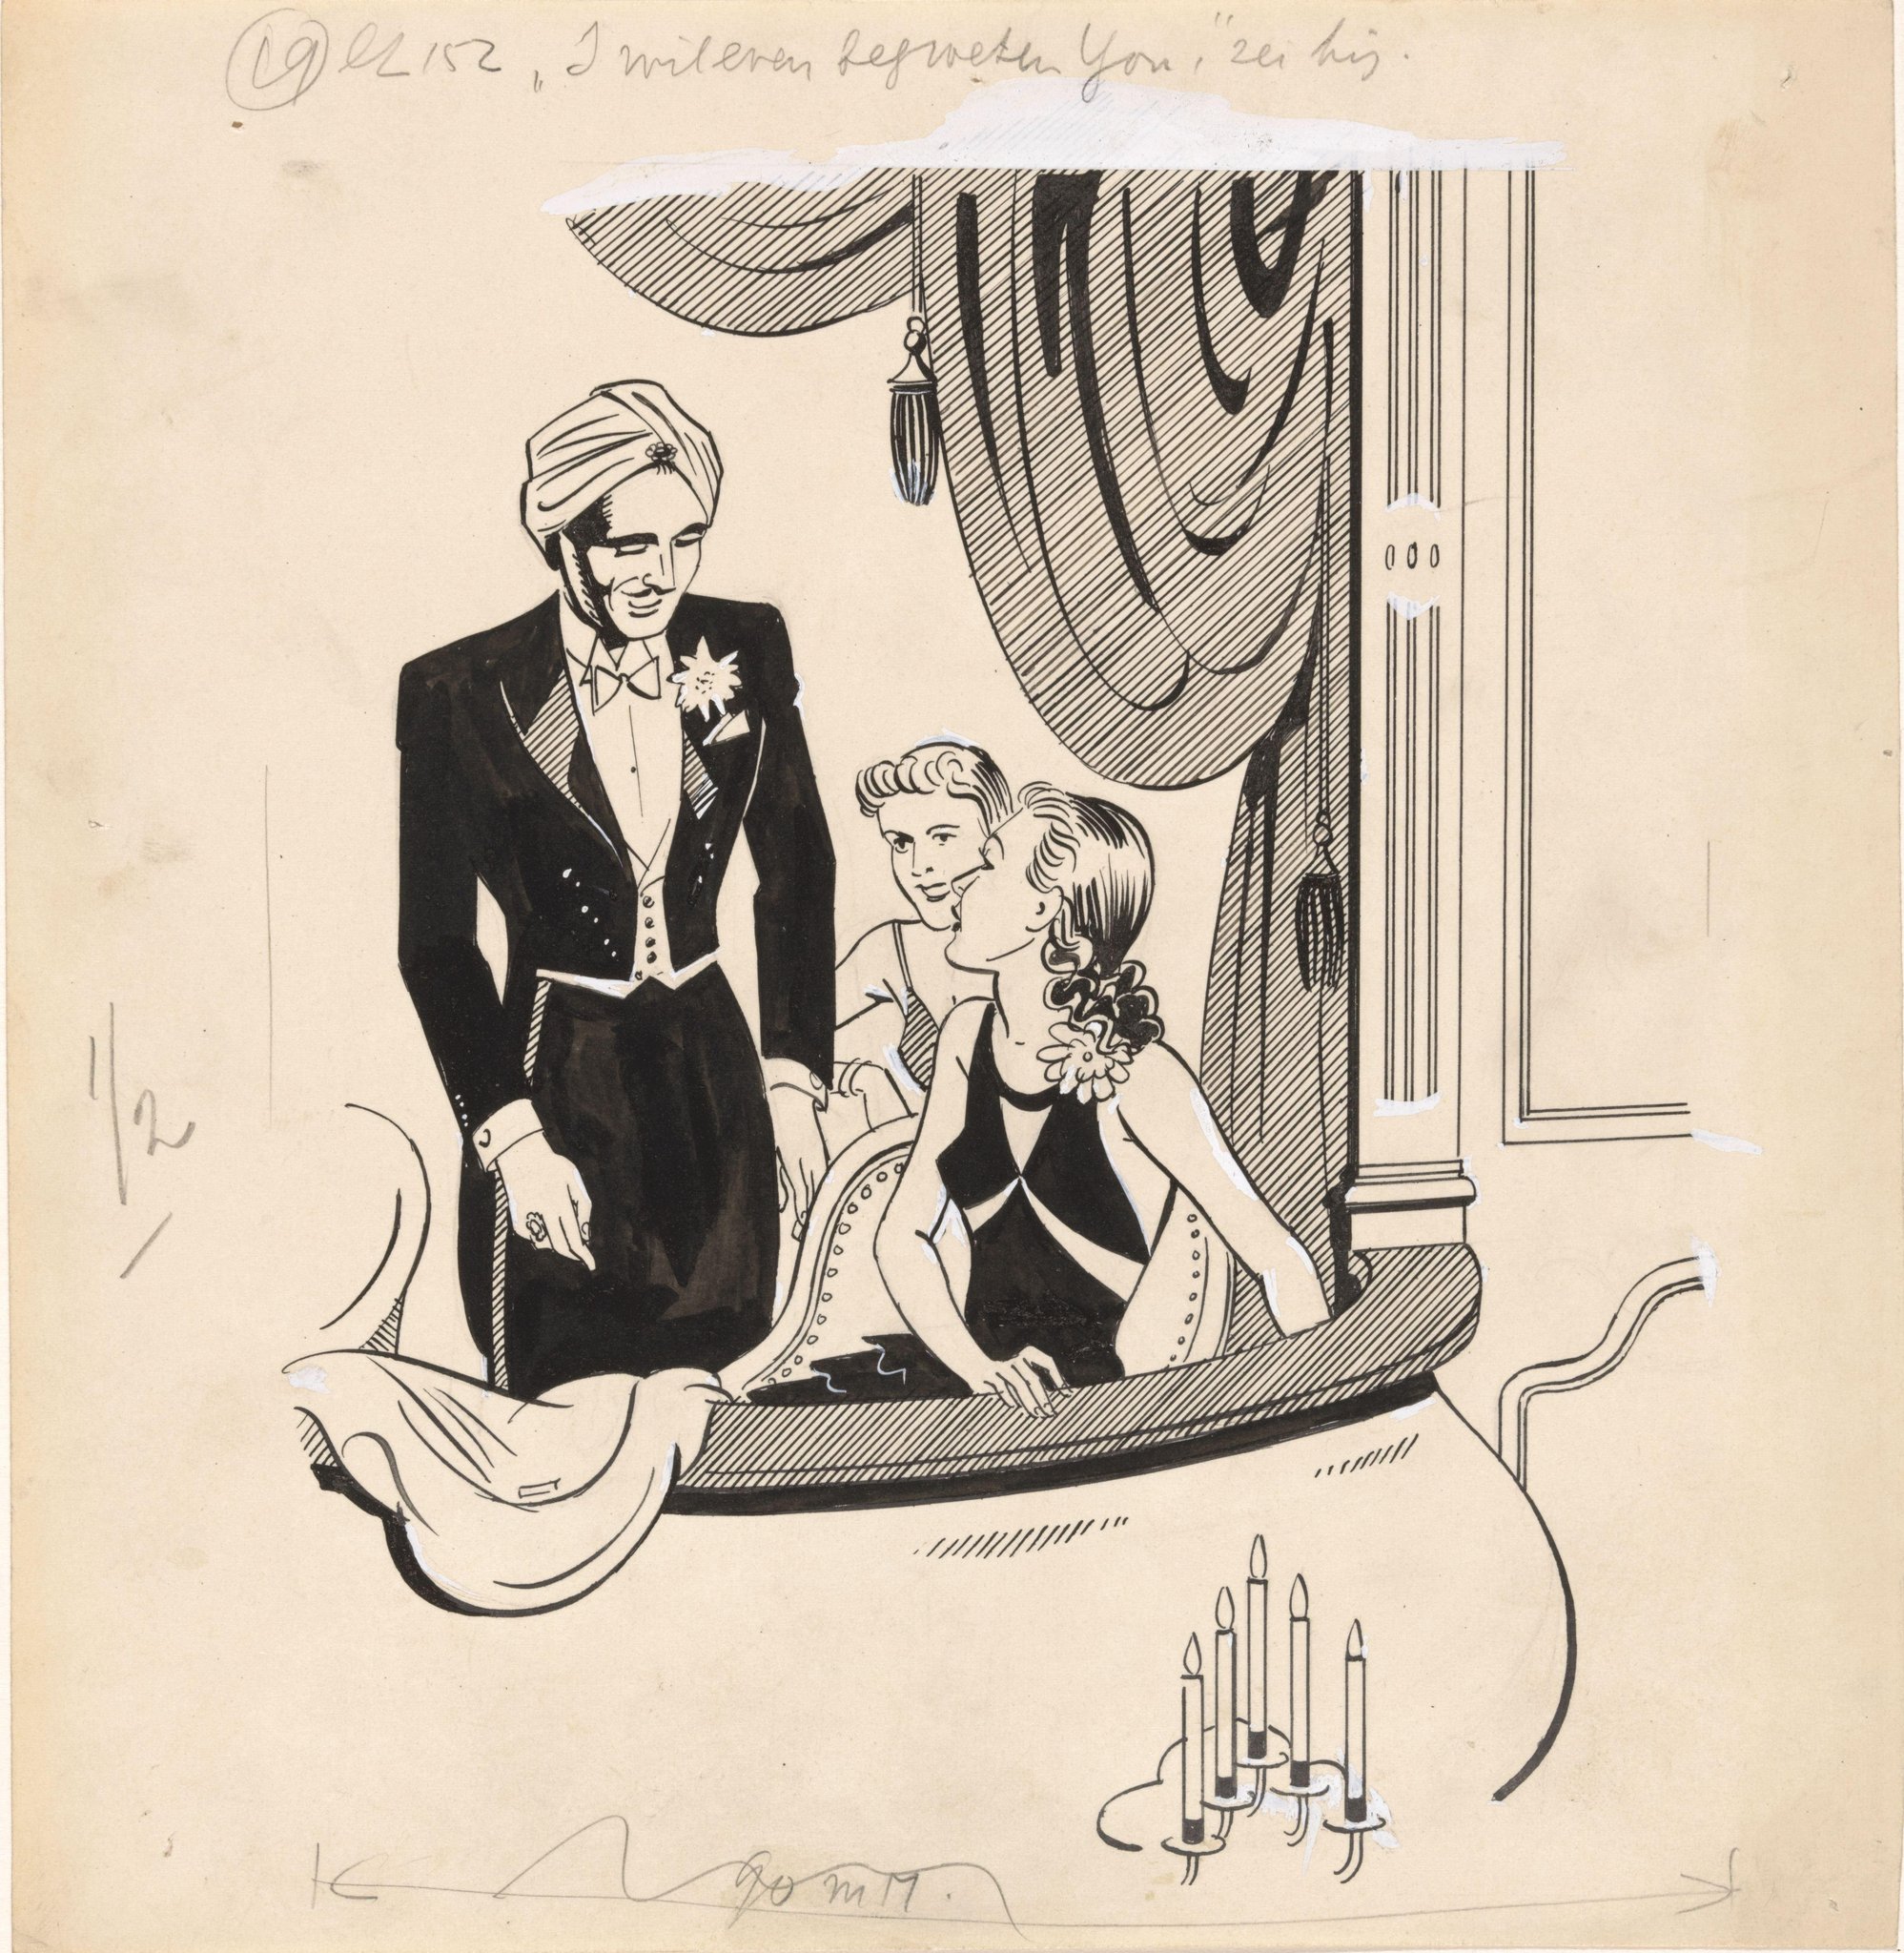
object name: drawing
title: Pepita en Agmed in een theaterloge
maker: hans borrebach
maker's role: draughtsman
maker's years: 1903-1991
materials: paint, ink, paper, pencil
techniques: brush, pen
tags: dress, gown: evening dress (+ women's clothes), boxes, loges ~ theatre, etc., head-gear: turban (+ men's clothes)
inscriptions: annotation: ‘19 blz 152 " I wil even zegweten you, "zei hij.’, :, collector's mark: Lugt 2228a, signature: ‘HANS./ BORREBACH’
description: Pepita zit in een loge in een theater en draait zich om naar Agmed, gekleed in een pak met vlinderdas en tulband, die achter haar staat. Op de achtergrond zit een jonge vrouw in de loge.